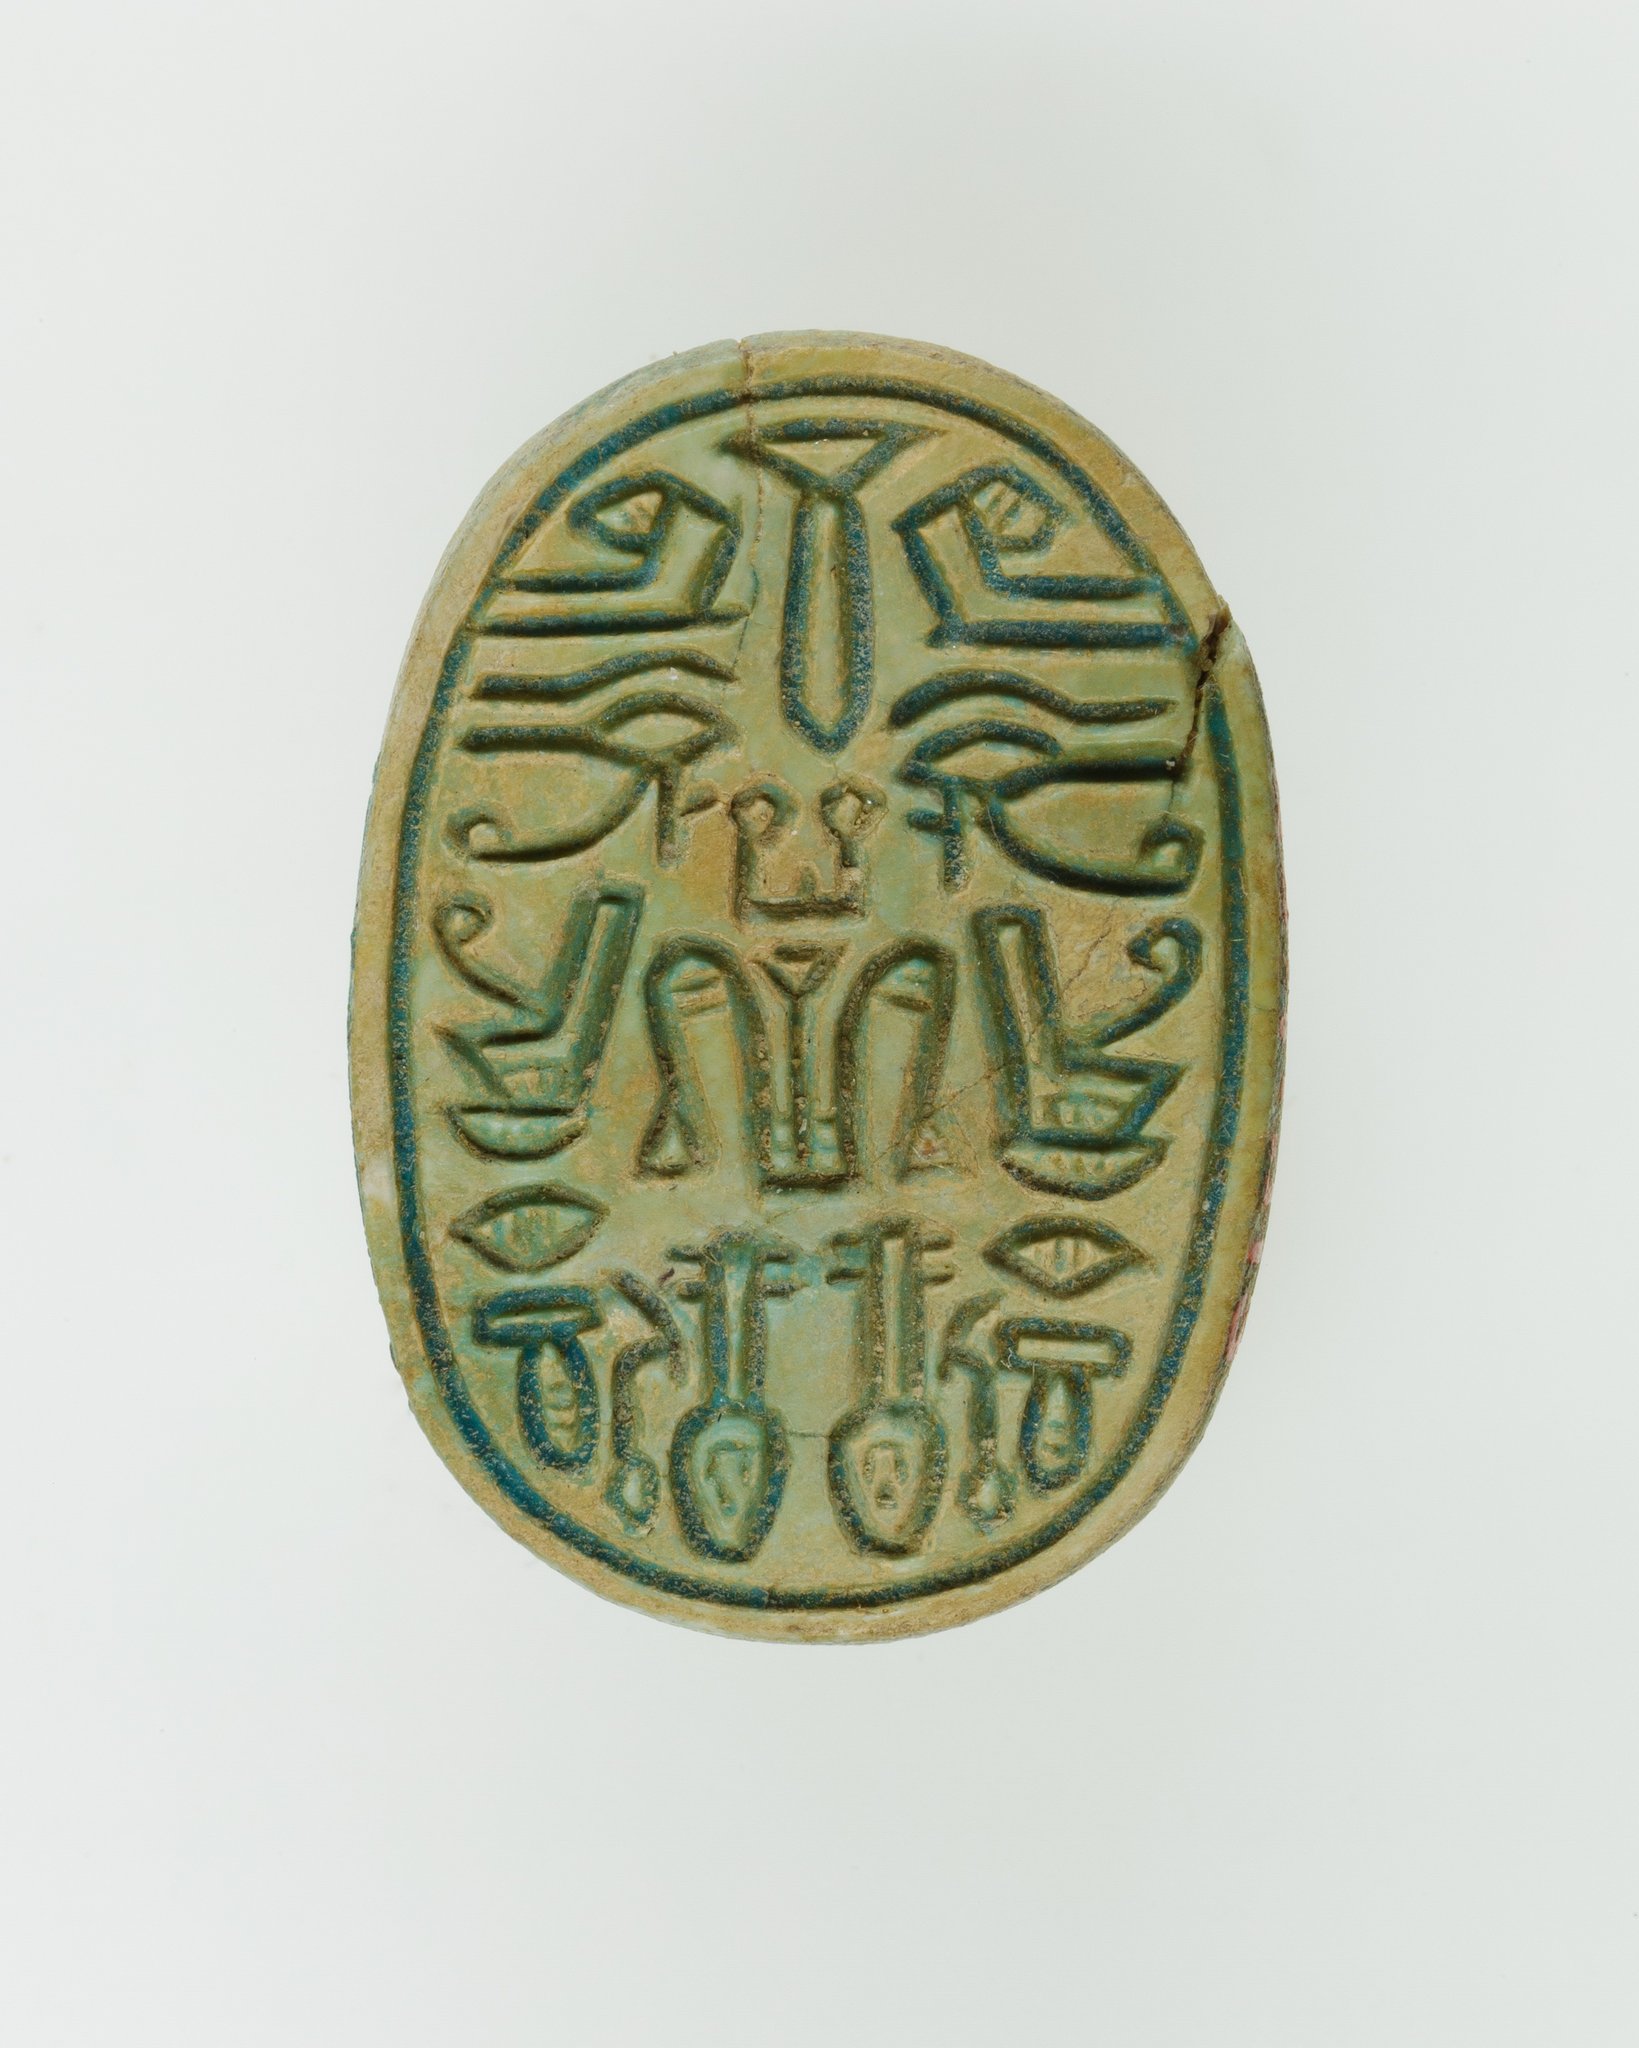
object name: scarab, hieroglyph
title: Scarab Inscribed with Hieroglyphs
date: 1760-1670 BCE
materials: stone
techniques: glazing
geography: egypt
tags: hieroglyphs,scarabs